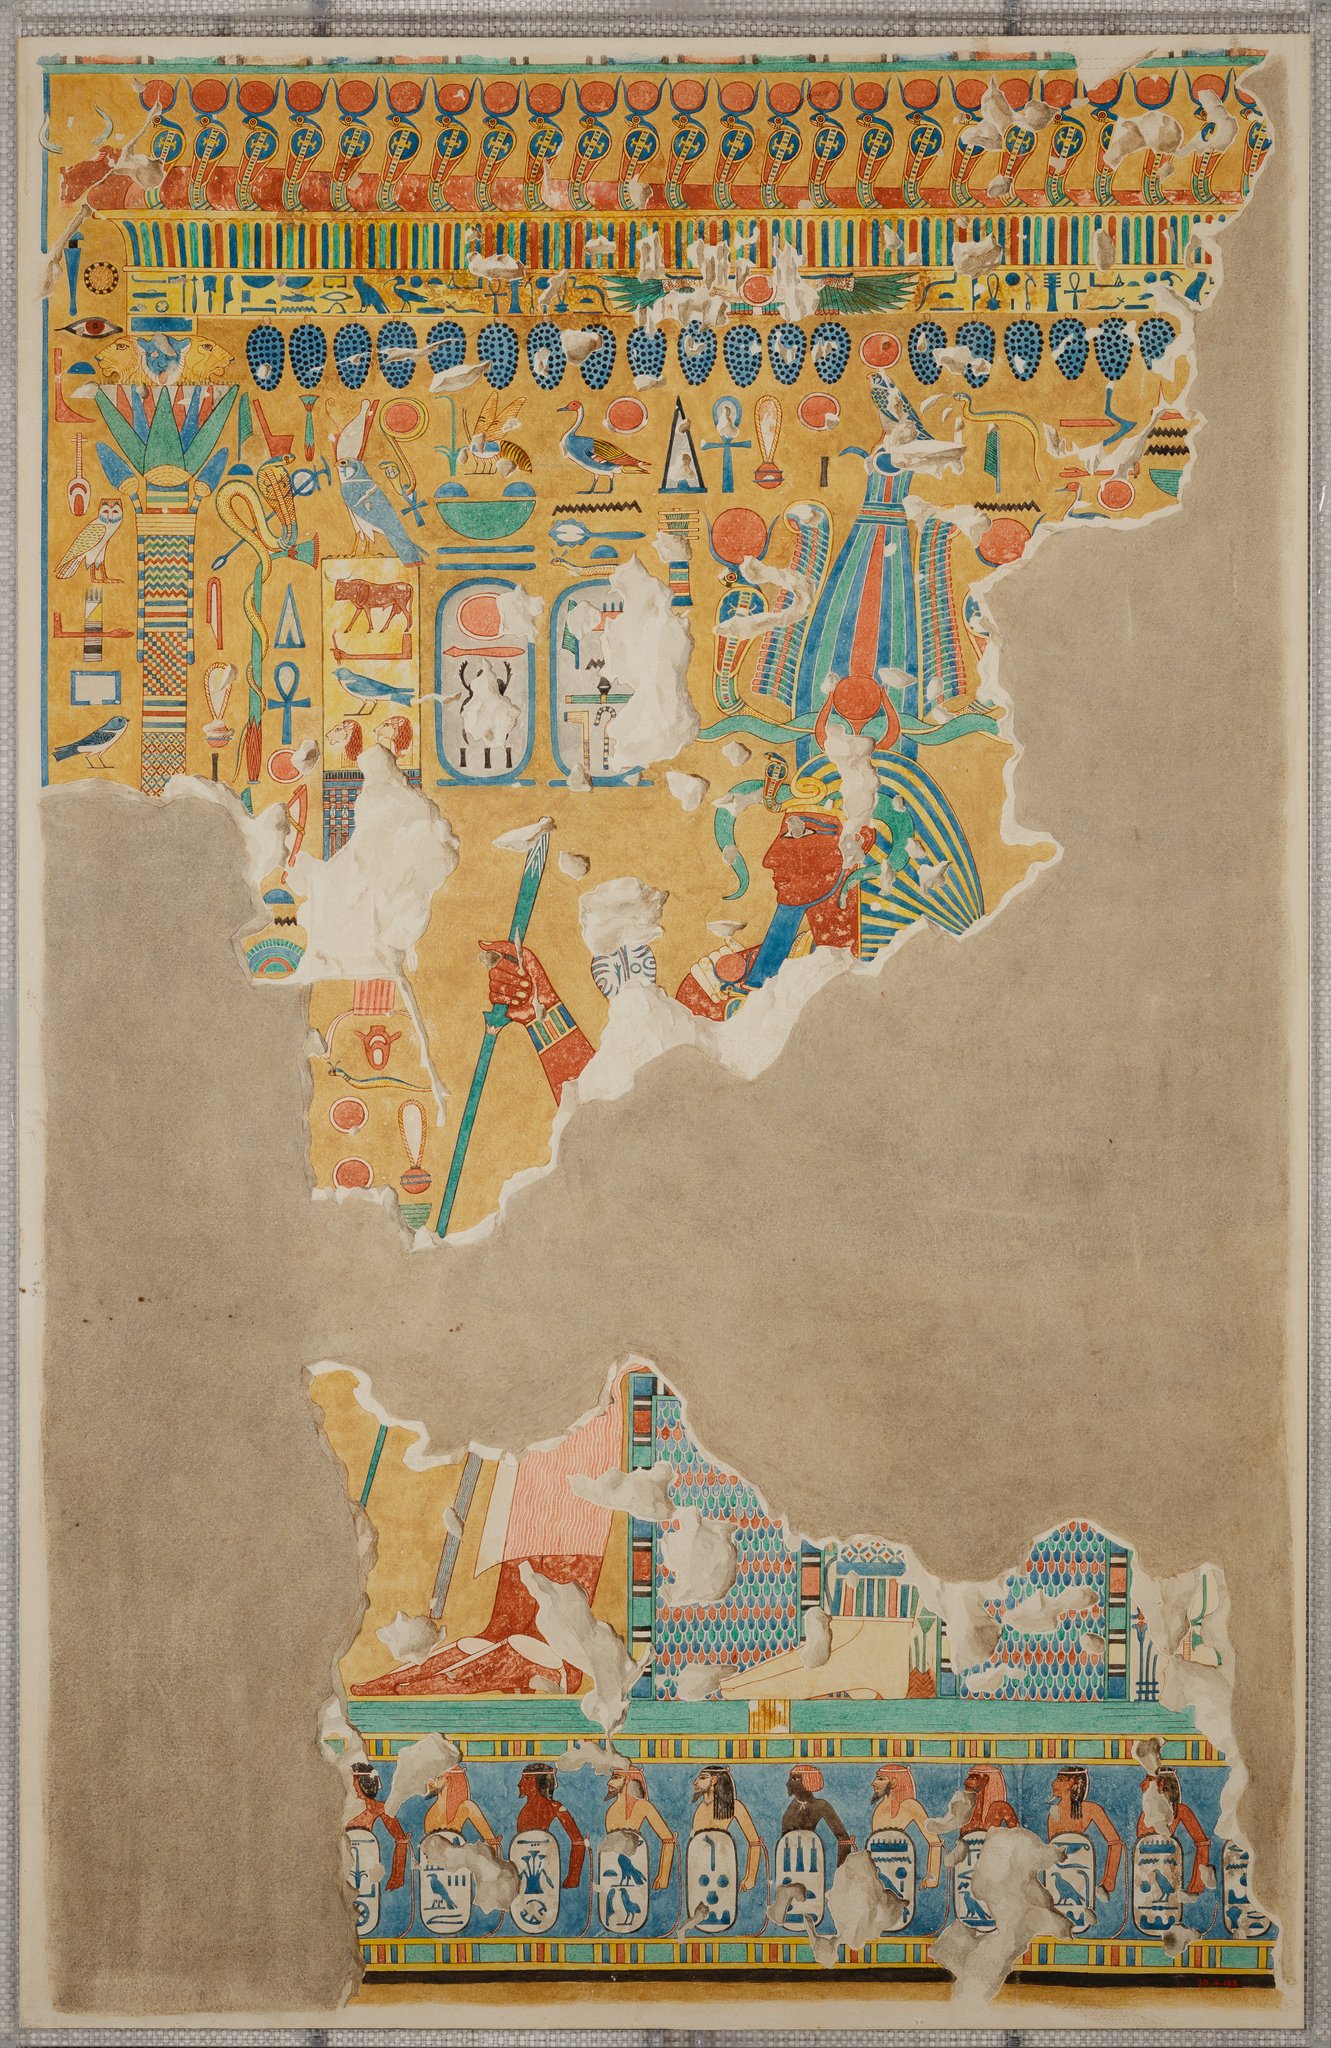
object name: facsimile, qenamun tt 93, amenhotep ii, kiosk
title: Amenhotep II with Maat Receiving New Year's Gifts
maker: hugh r. hopgood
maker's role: artist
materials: paper, paint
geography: egypt